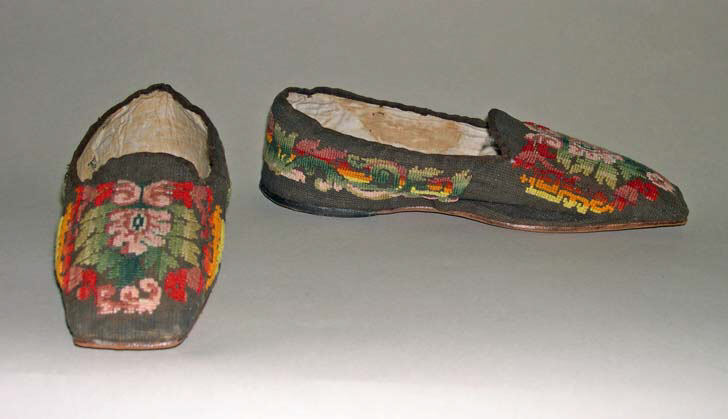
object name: slipper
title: Slippers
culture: american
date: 1834-1866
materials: leather, silk